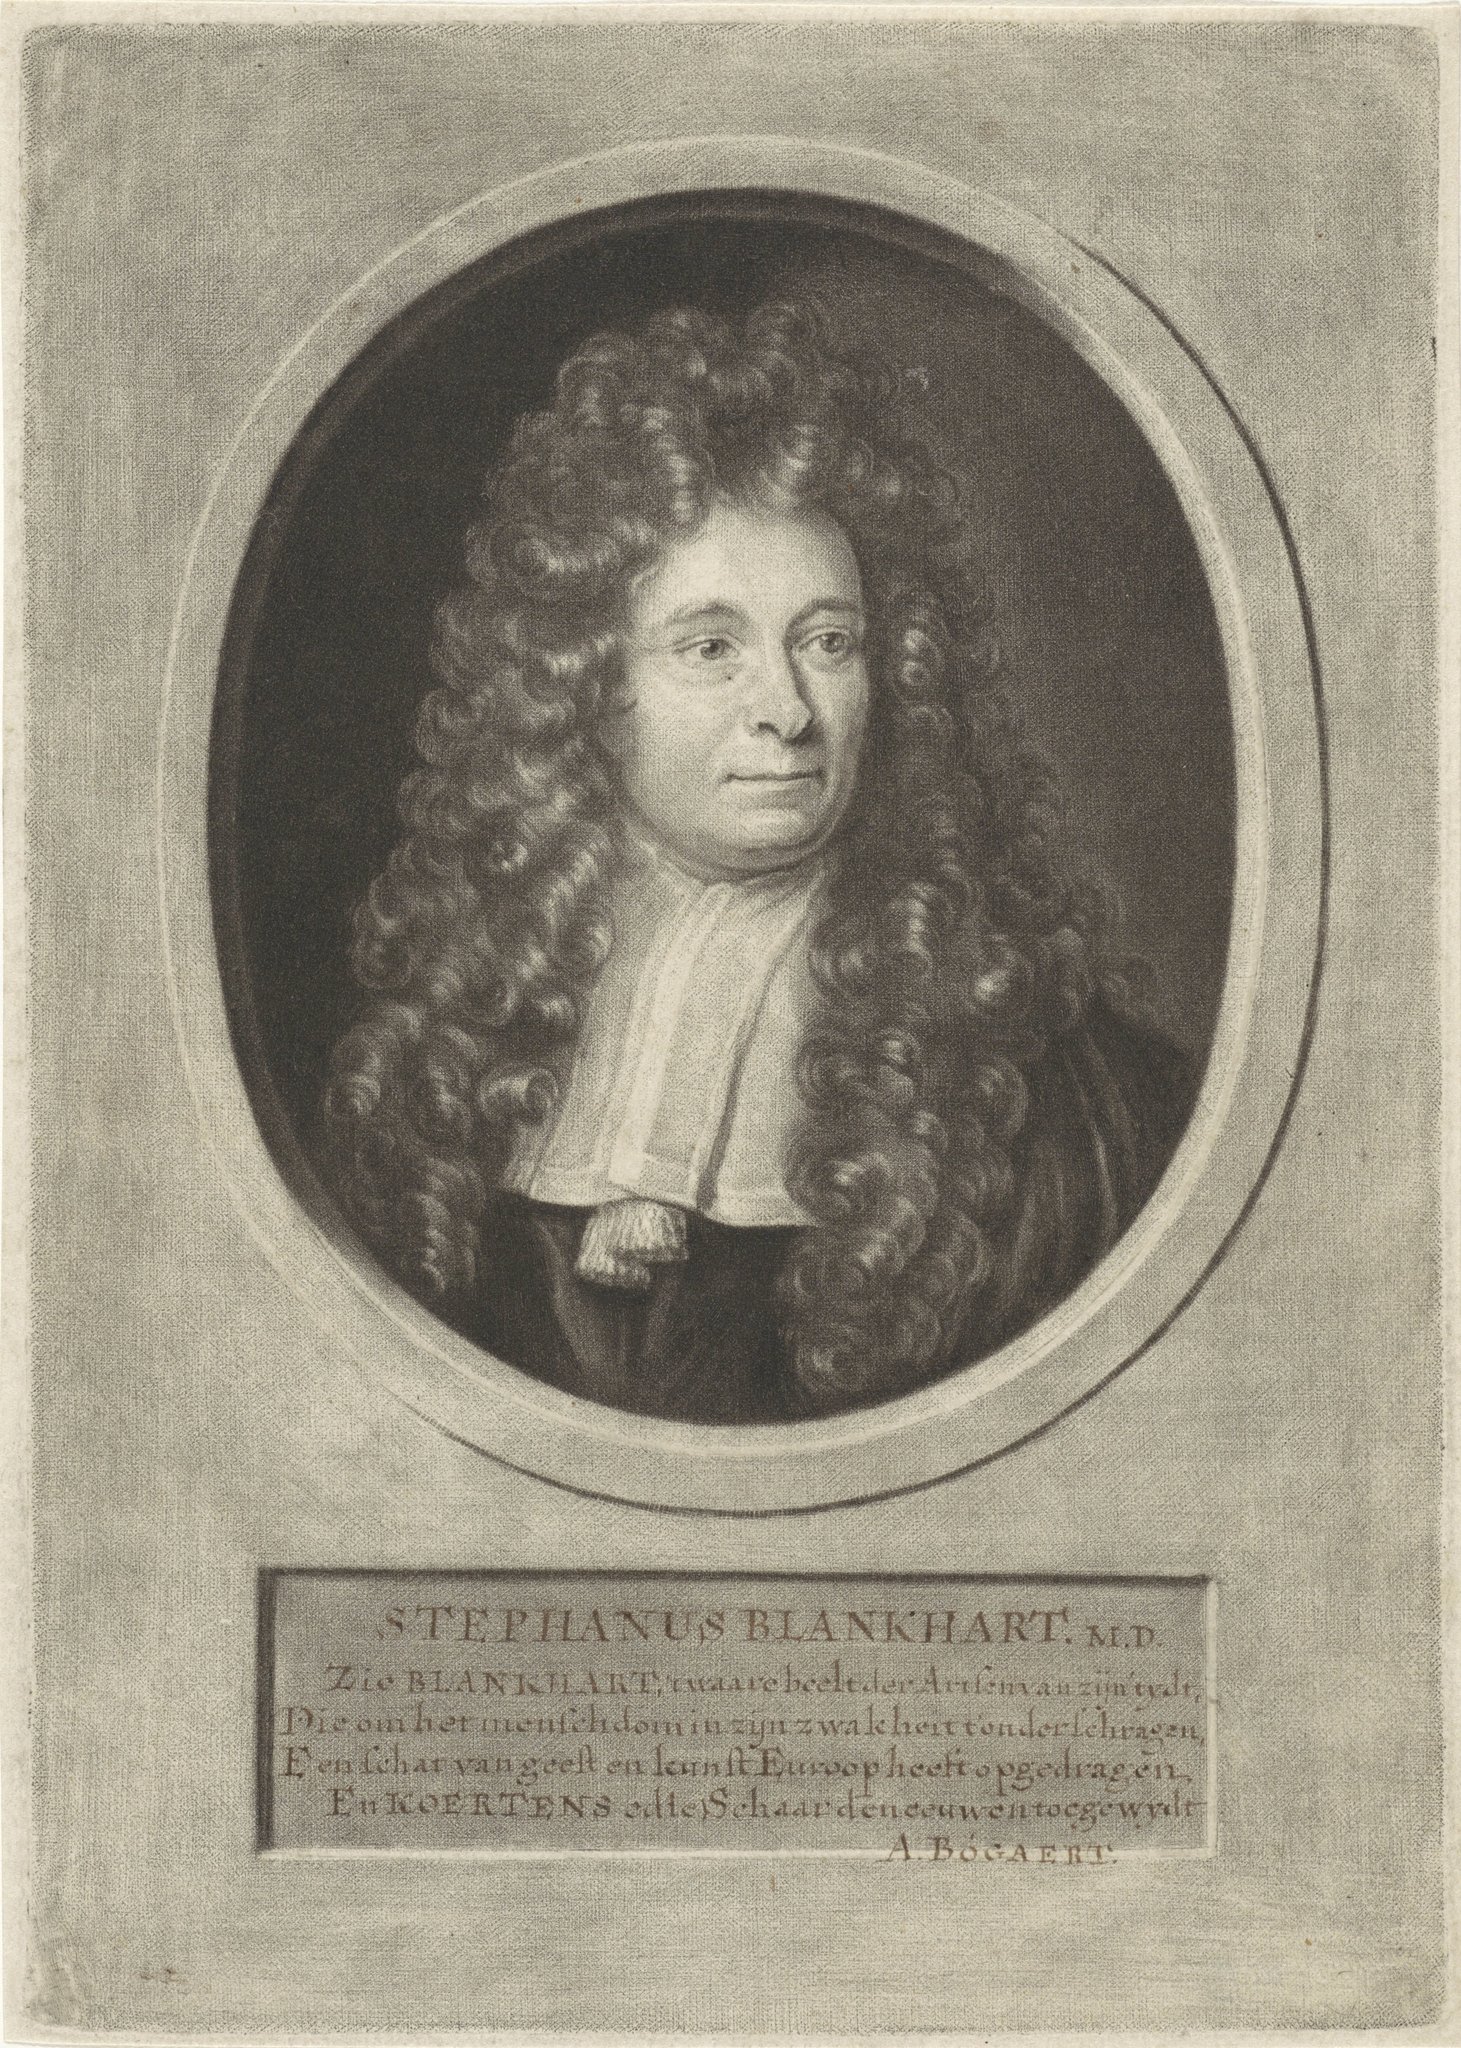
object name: print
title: Portret van Steven Blankaart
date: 1670-1724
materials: ink, paper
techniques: pen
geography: amsterdam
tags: wig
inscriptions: collector's mark: Lugt 2228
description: Steven Blankaart, Nederlands dichter en geneesheer te Amsterdam.